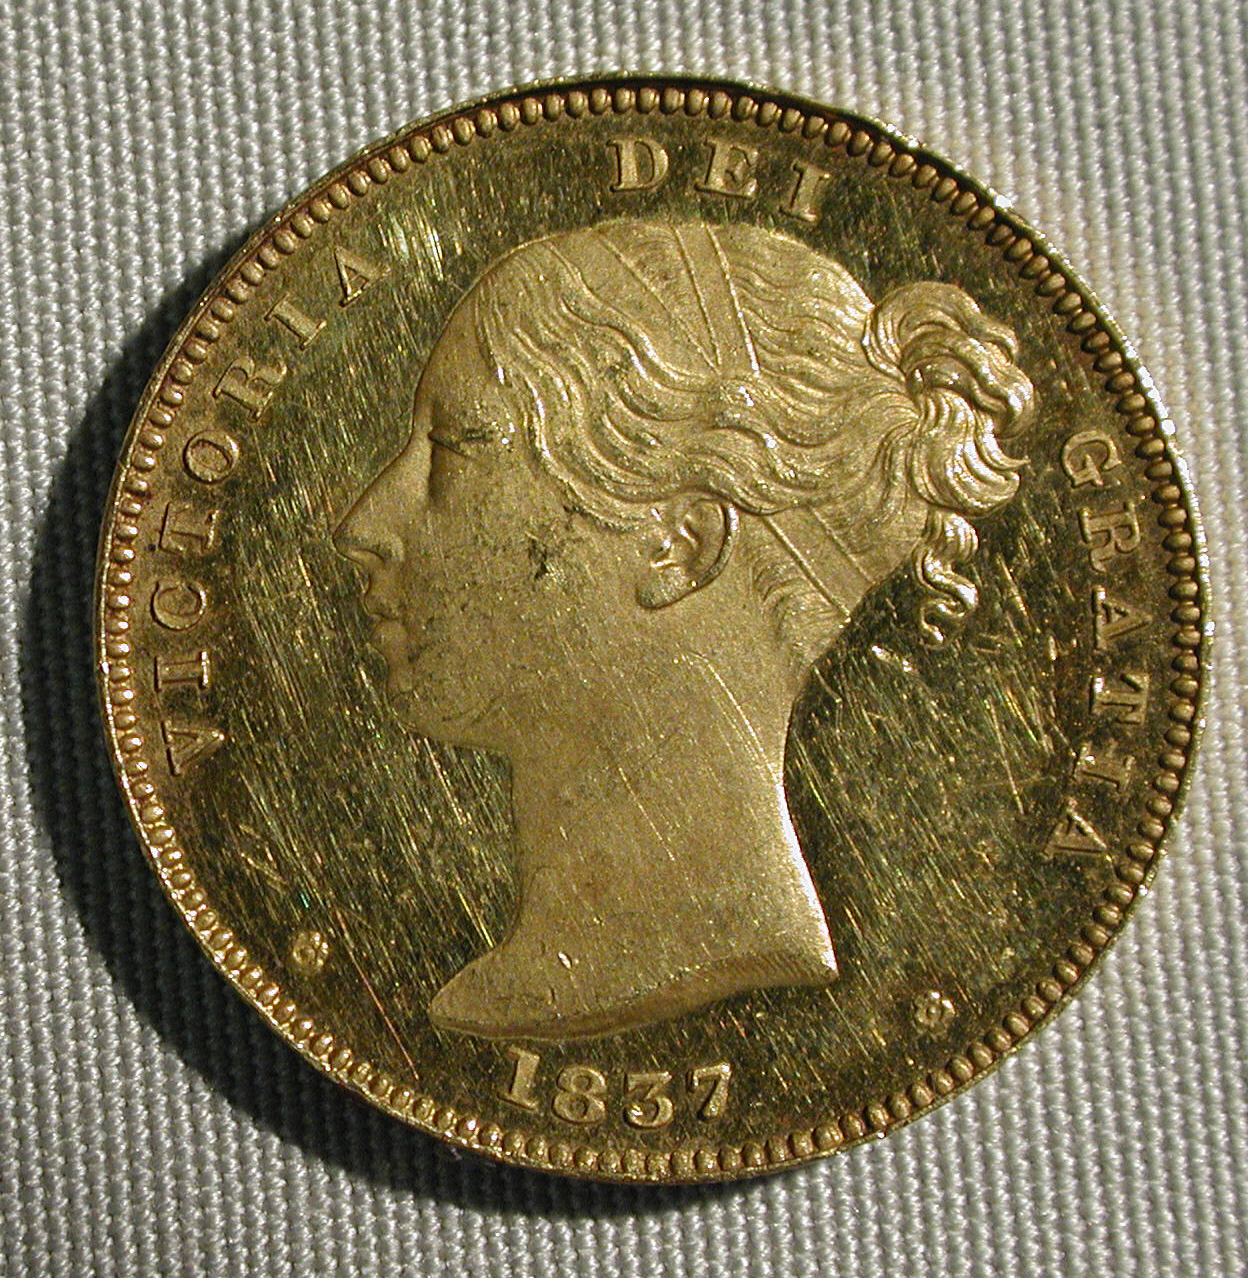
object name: proof sovereign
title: Victoria proof sovereign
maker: william wyon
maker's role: artist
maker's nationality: british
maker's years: 1795-1851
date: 1837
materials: gold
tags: profiles,women,coins,coat of arms